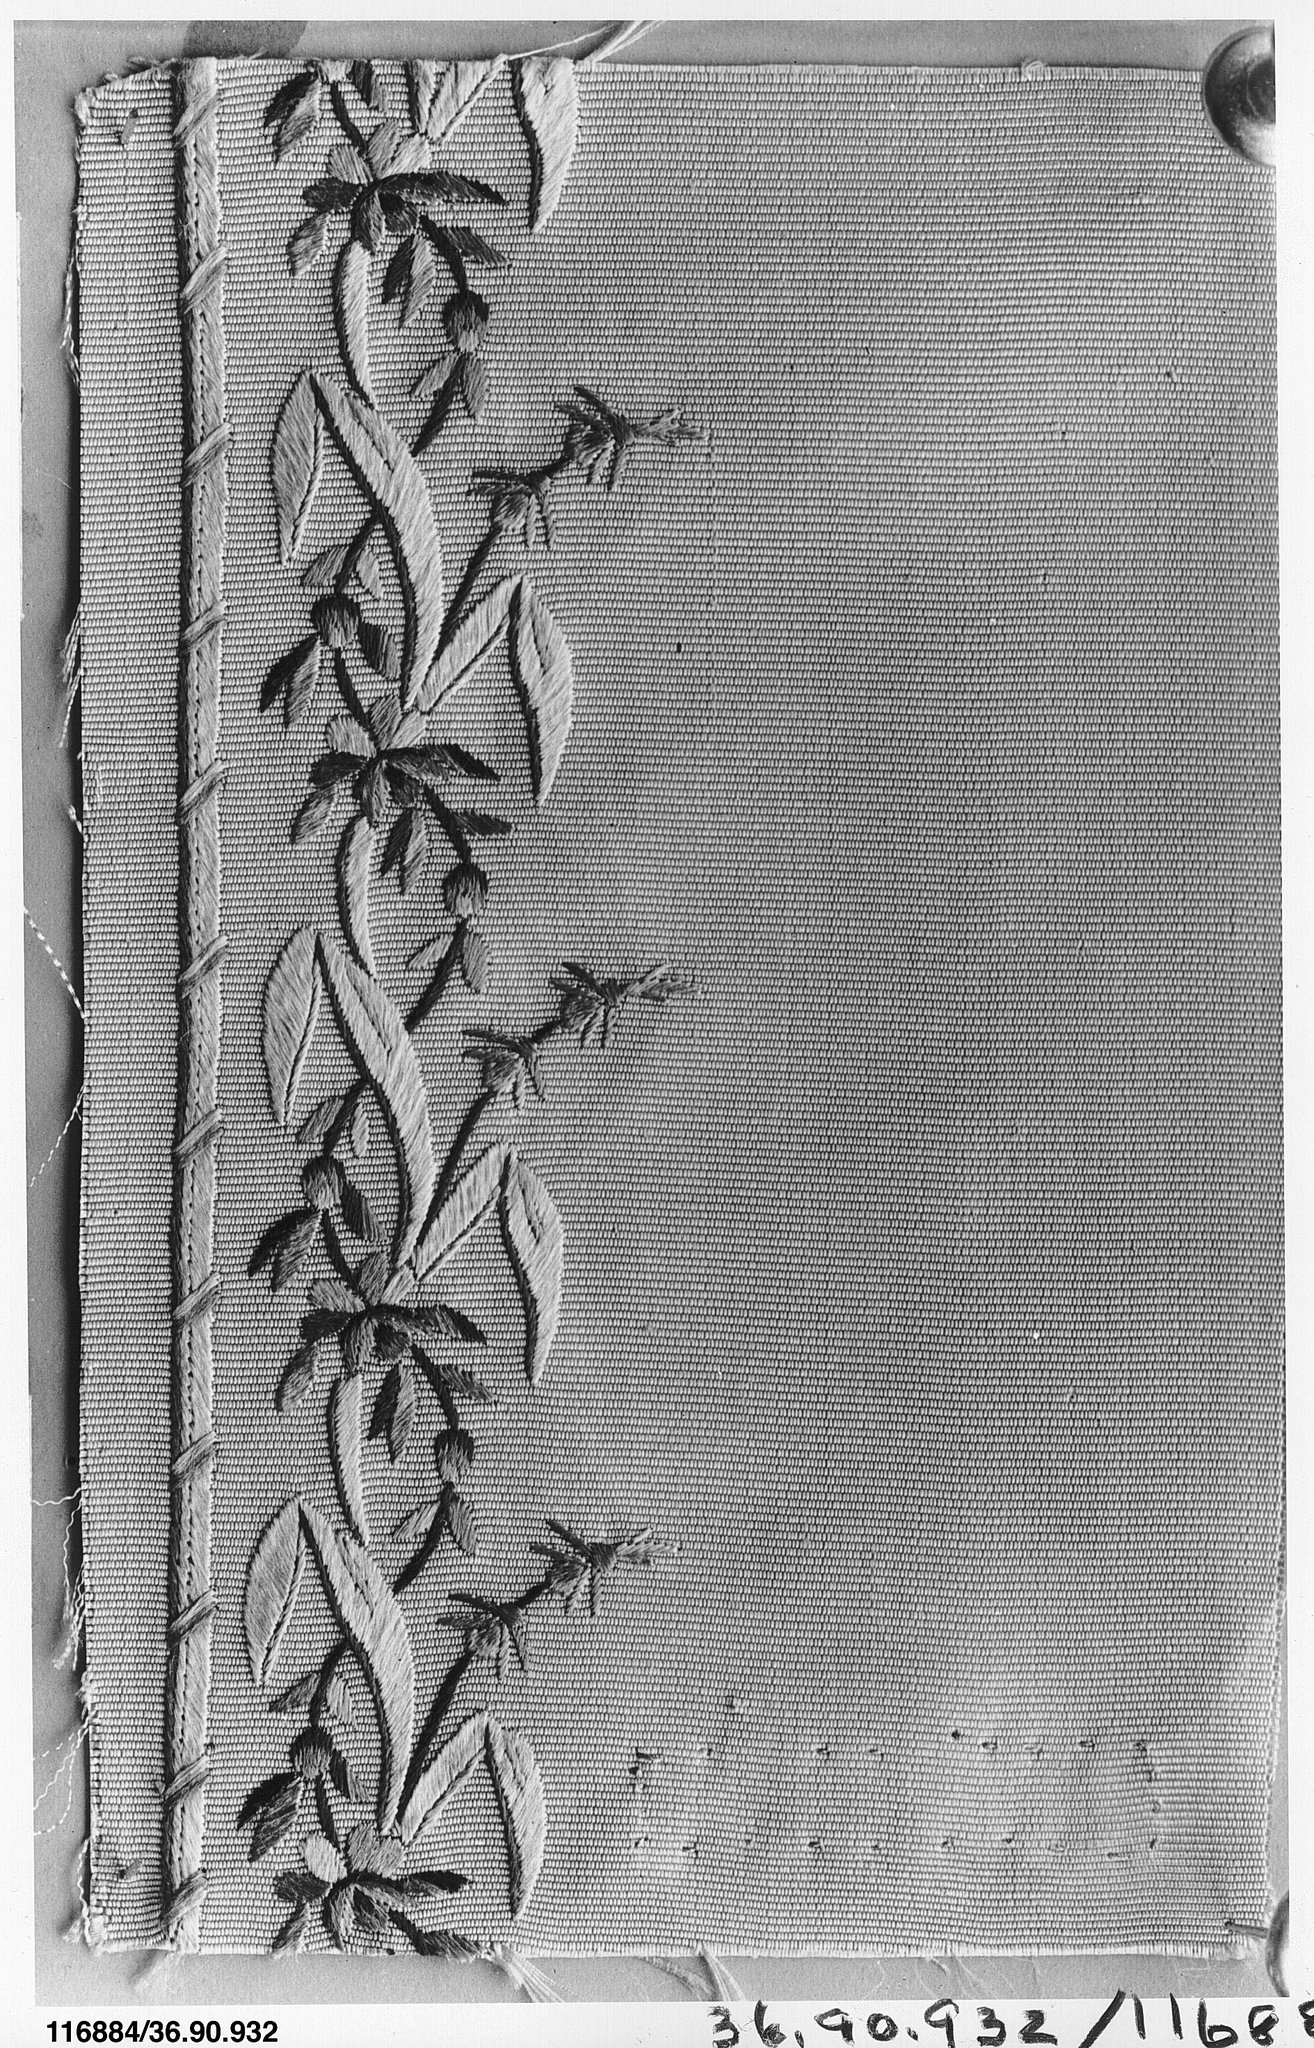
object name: sample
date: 1801-1833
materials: silk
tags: flowers